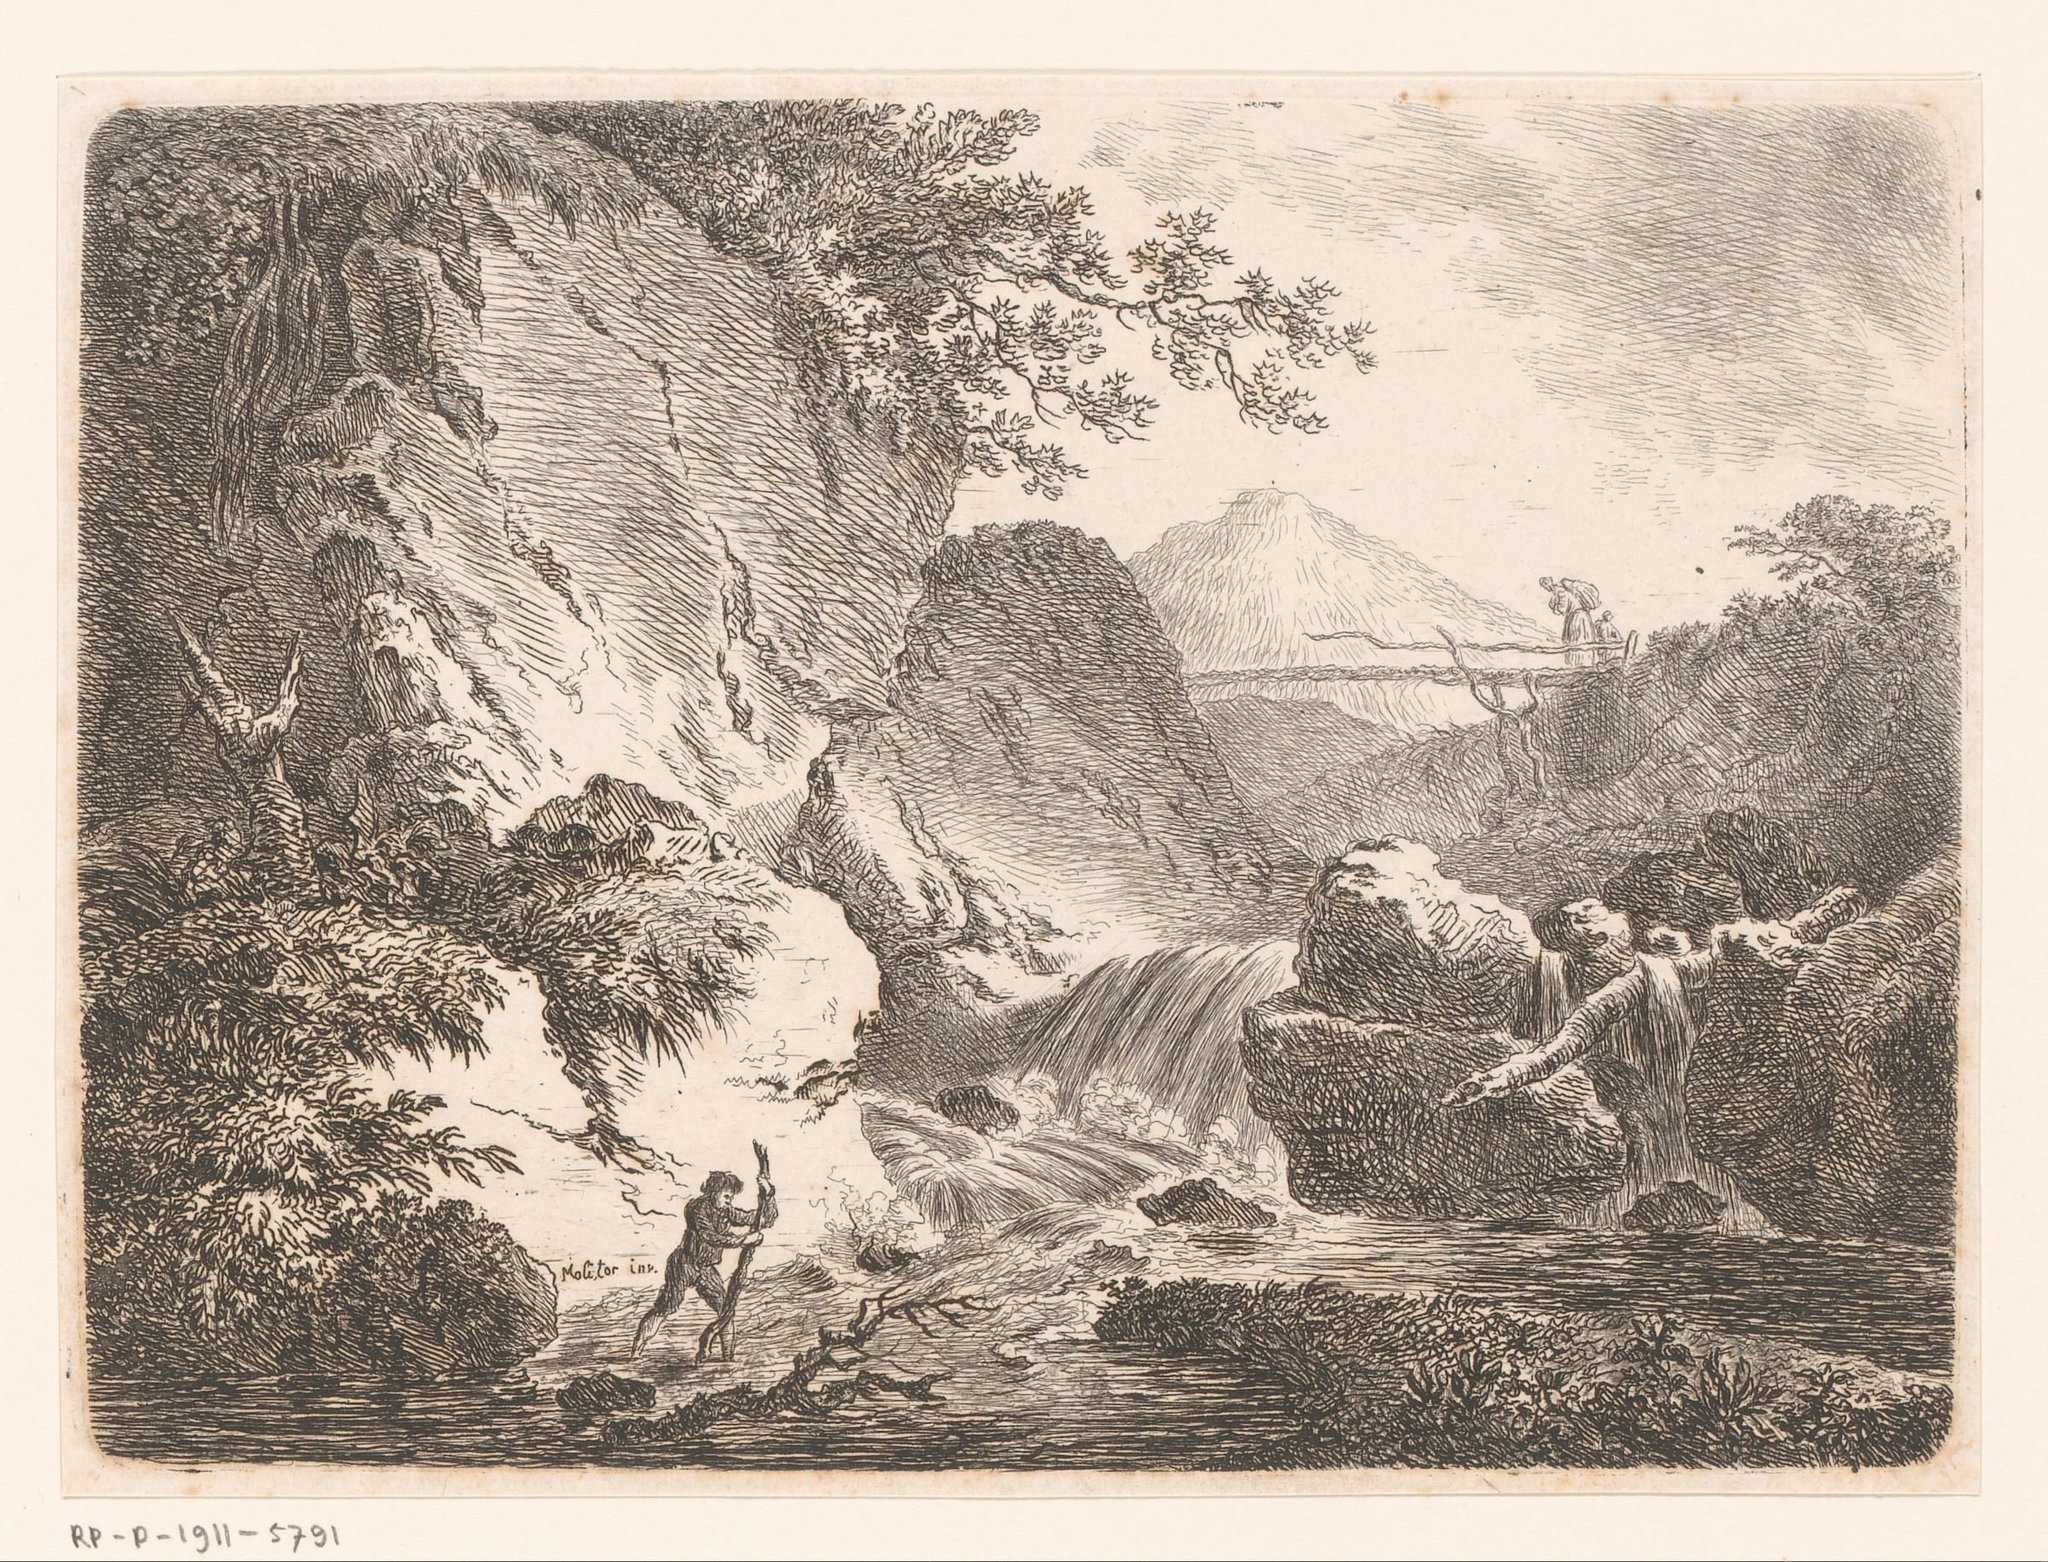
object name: print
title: Landschappen door Legros naar verschillende meesters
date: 1769-1834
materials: paper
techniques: etching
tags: rapids, mountains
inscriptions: collector's mark: Lugt 2228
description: Maakt deel uit van een serie met landschappen door Legros naar verschillende meesters.